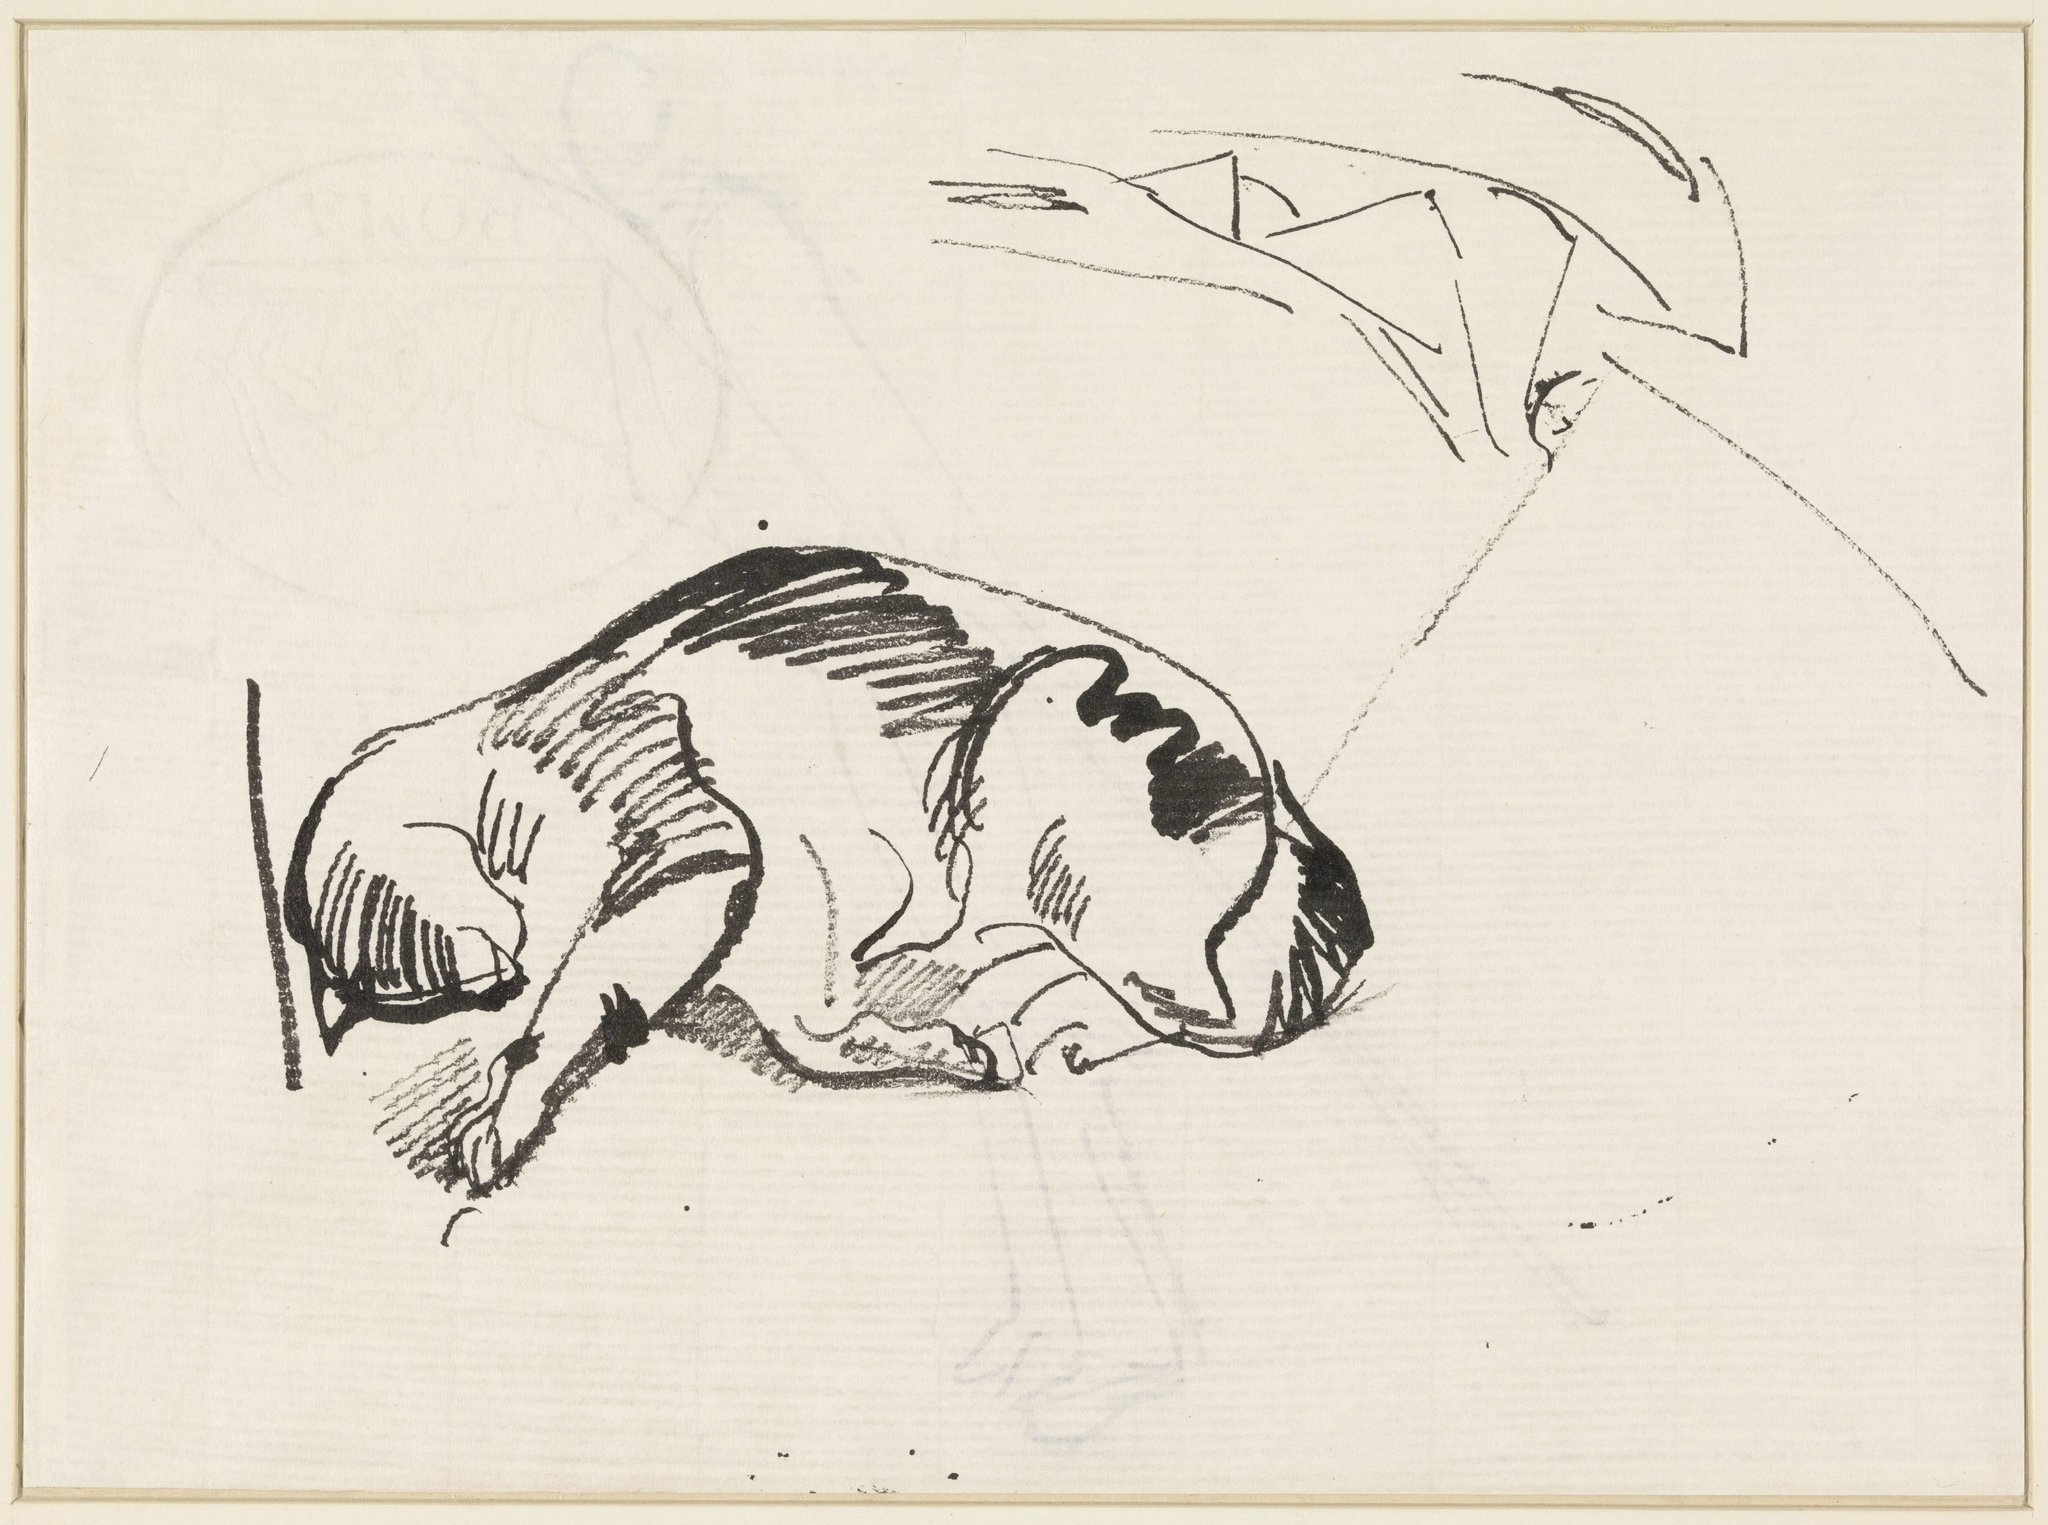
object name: drawing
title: Liggende kat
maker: rik wouters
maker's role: draughtsman, print maker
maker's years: 1882-1916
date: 1915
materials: ink, paper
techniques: pen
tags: cat